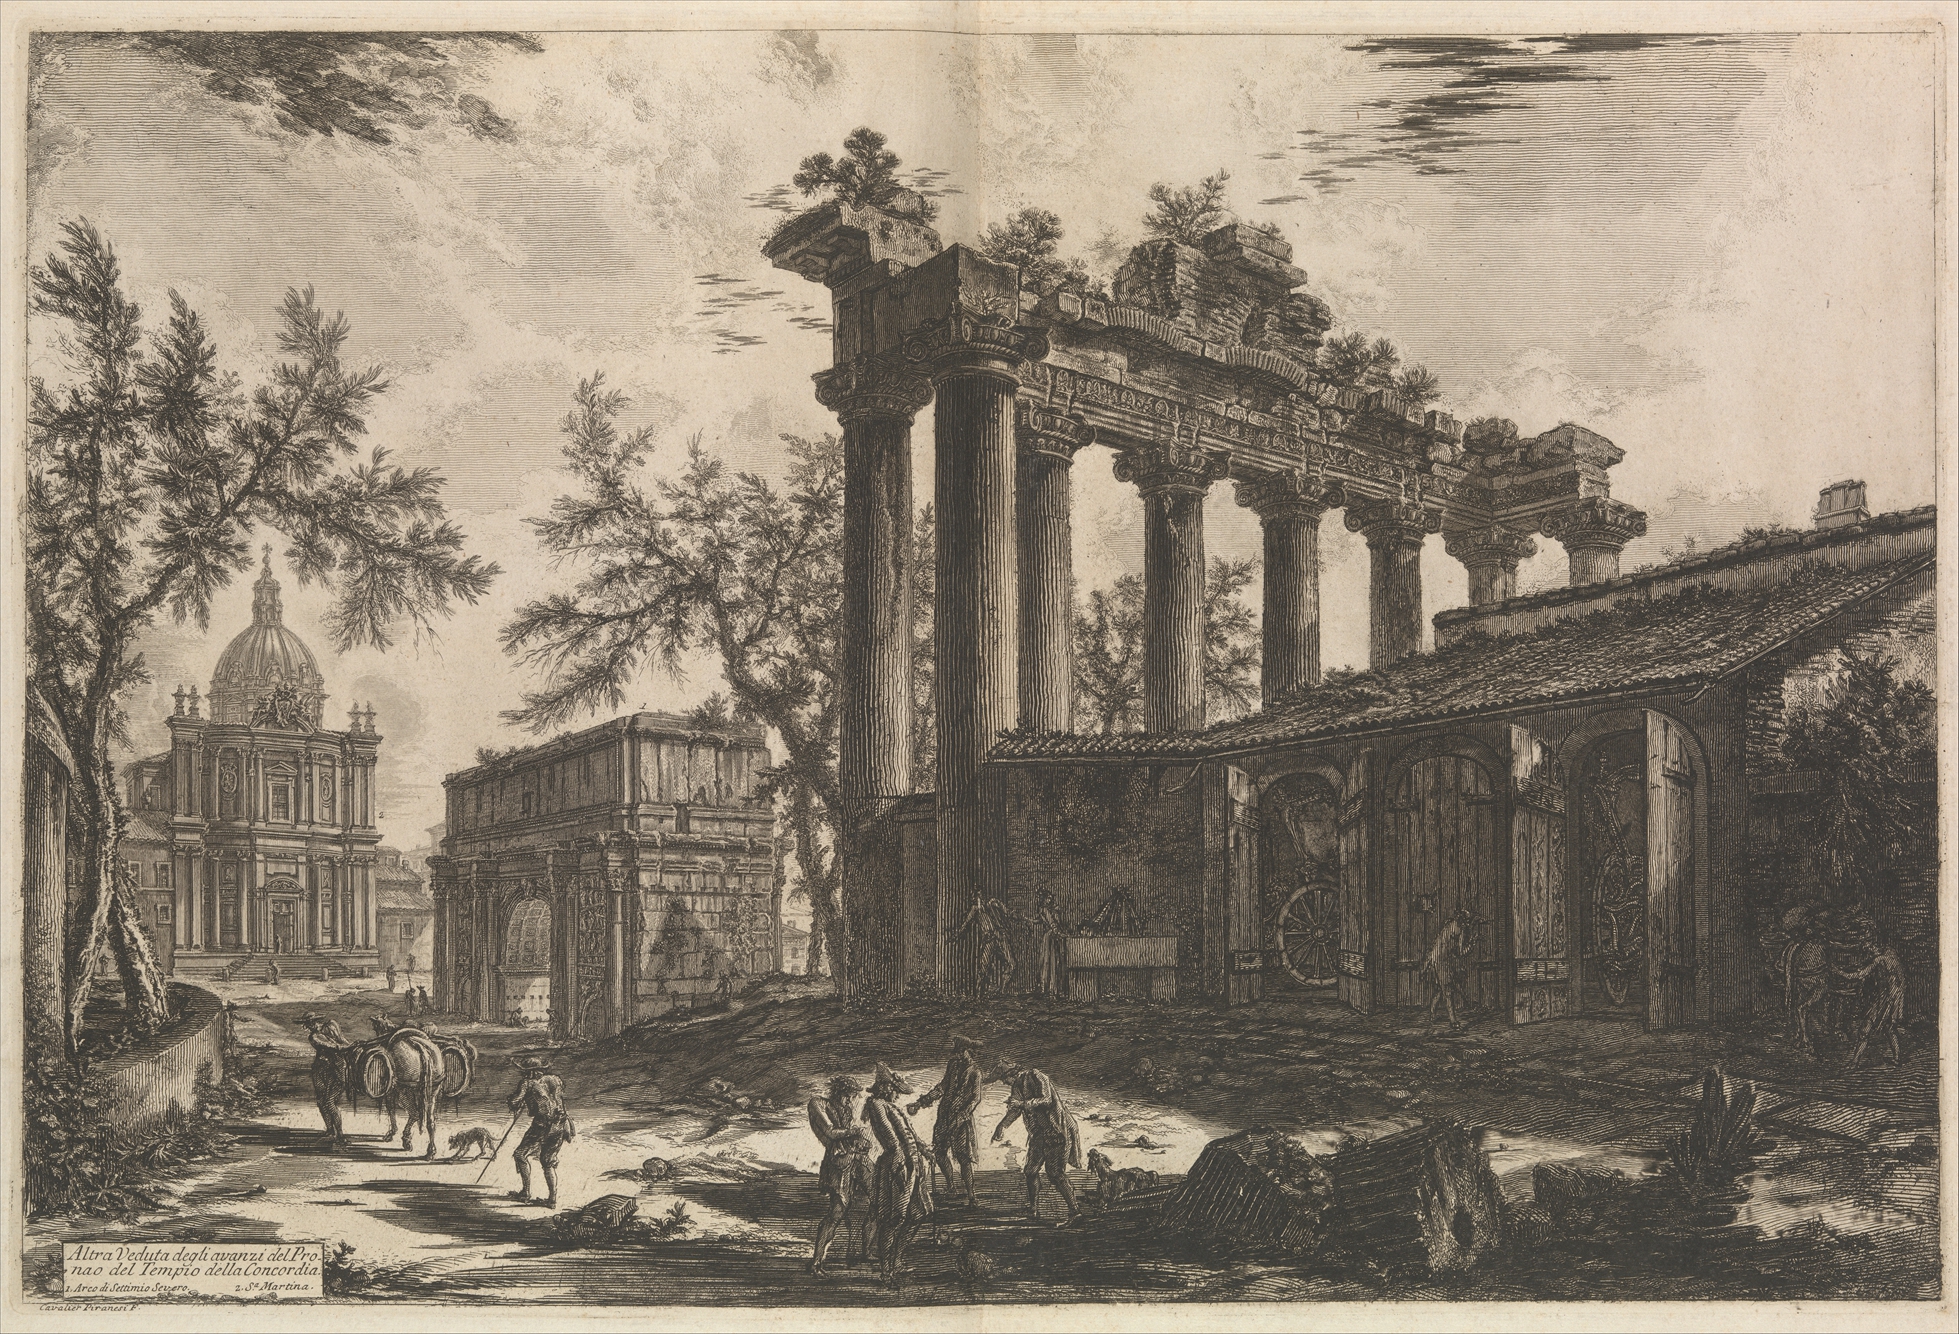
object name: print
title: Another view of the remains of the Pronaos of the Temple of Concord (The Temple of Saturn with Arch of Septimius Severus in left background), from "Vedute di Roma" (Views of Rome), part I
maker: giovanni battista piranesi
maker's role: artist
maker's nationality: italian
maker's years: 1720-1778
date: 1750-1778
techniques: etching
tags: human figures,temples,ruins,rome